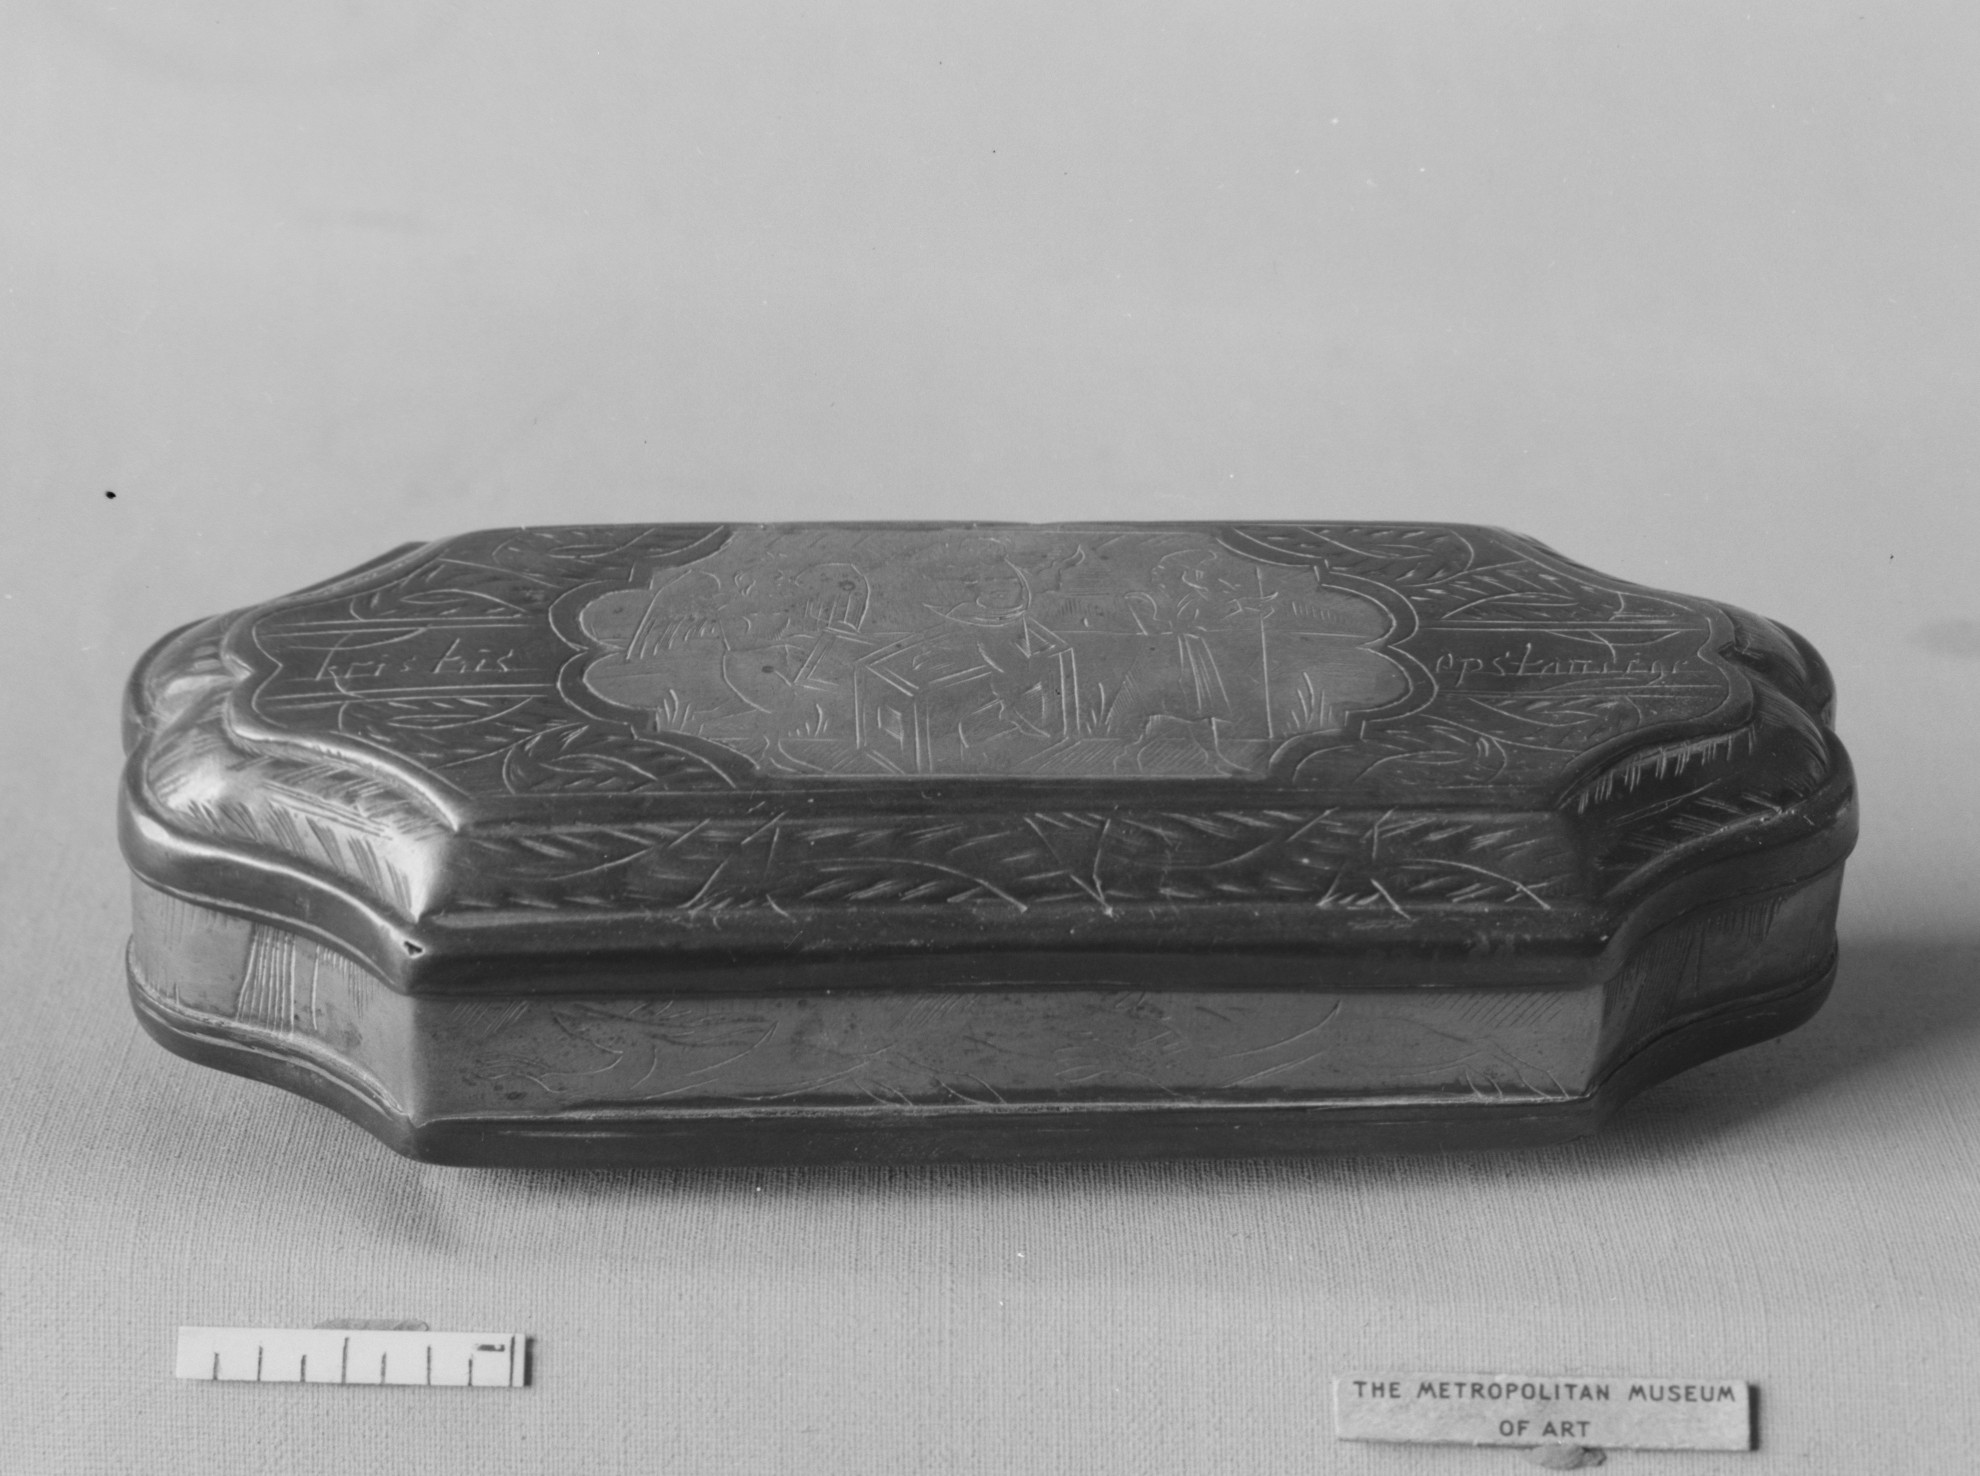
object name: tobacco box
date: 1601-1700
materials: brass, copper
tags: men,angels